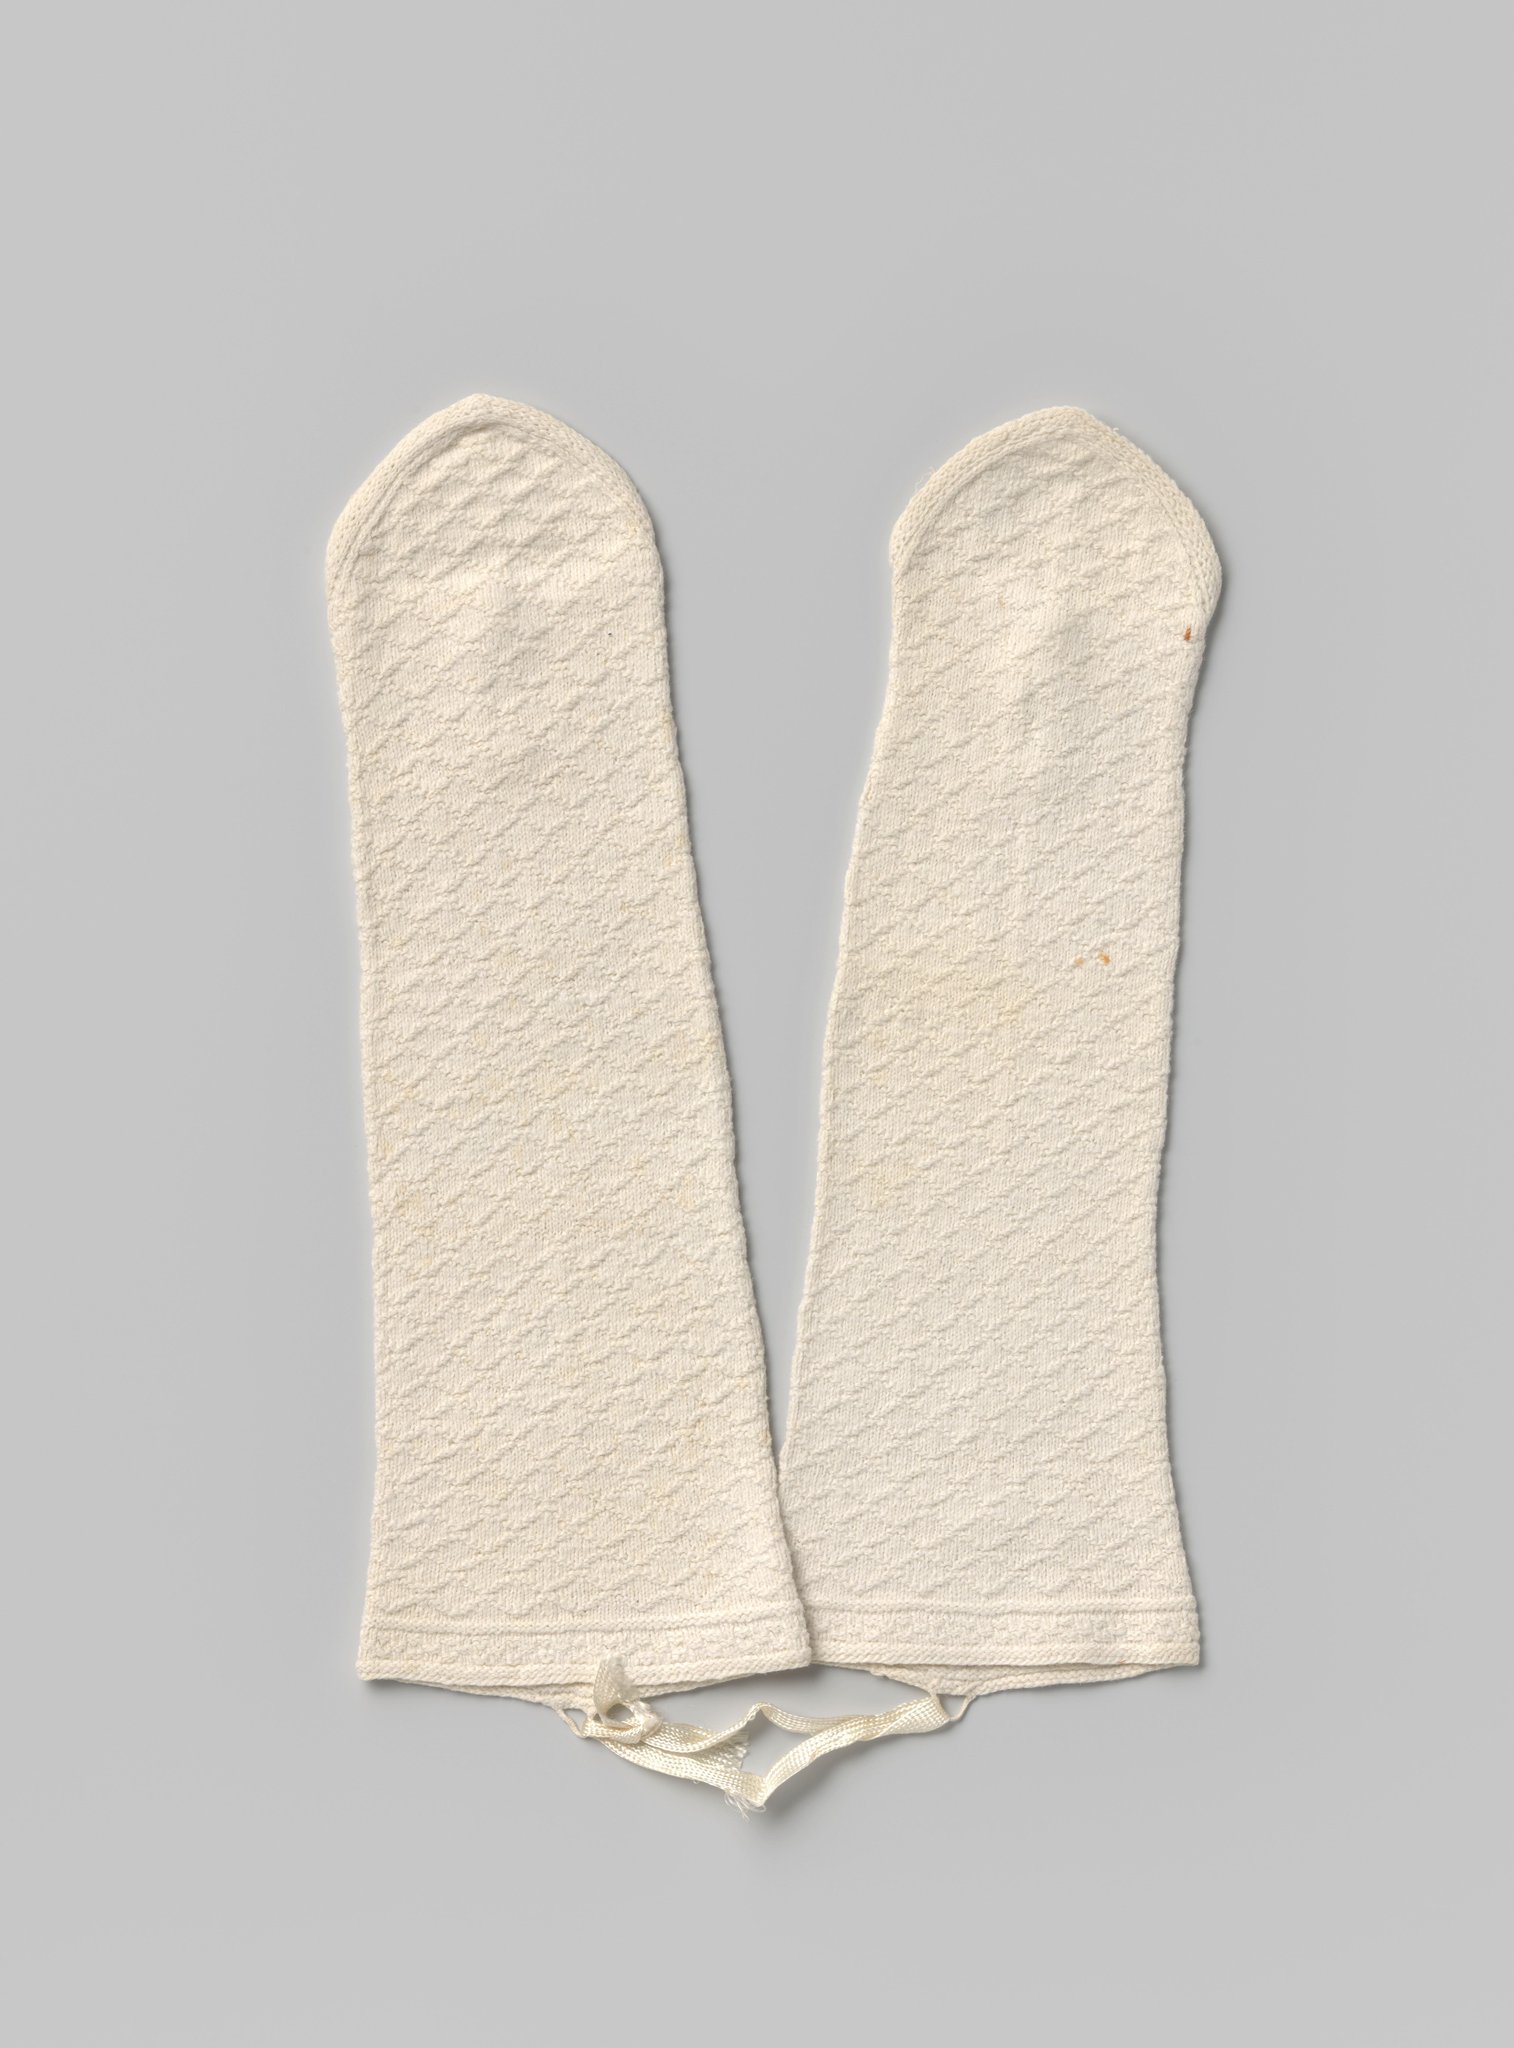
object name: mitt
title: Mitaine van witte gebreide katoen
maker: Anonymous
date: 1750-1800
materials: cotton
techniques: knitting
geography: western europe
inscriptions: : ‘AEL / 6’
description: Mitaine van witte gebreide katoen, met een patroon van ruiten. Onderaan een split met een haak en trensje. Gladde omtrek. Gemerkt: AEL / 6.